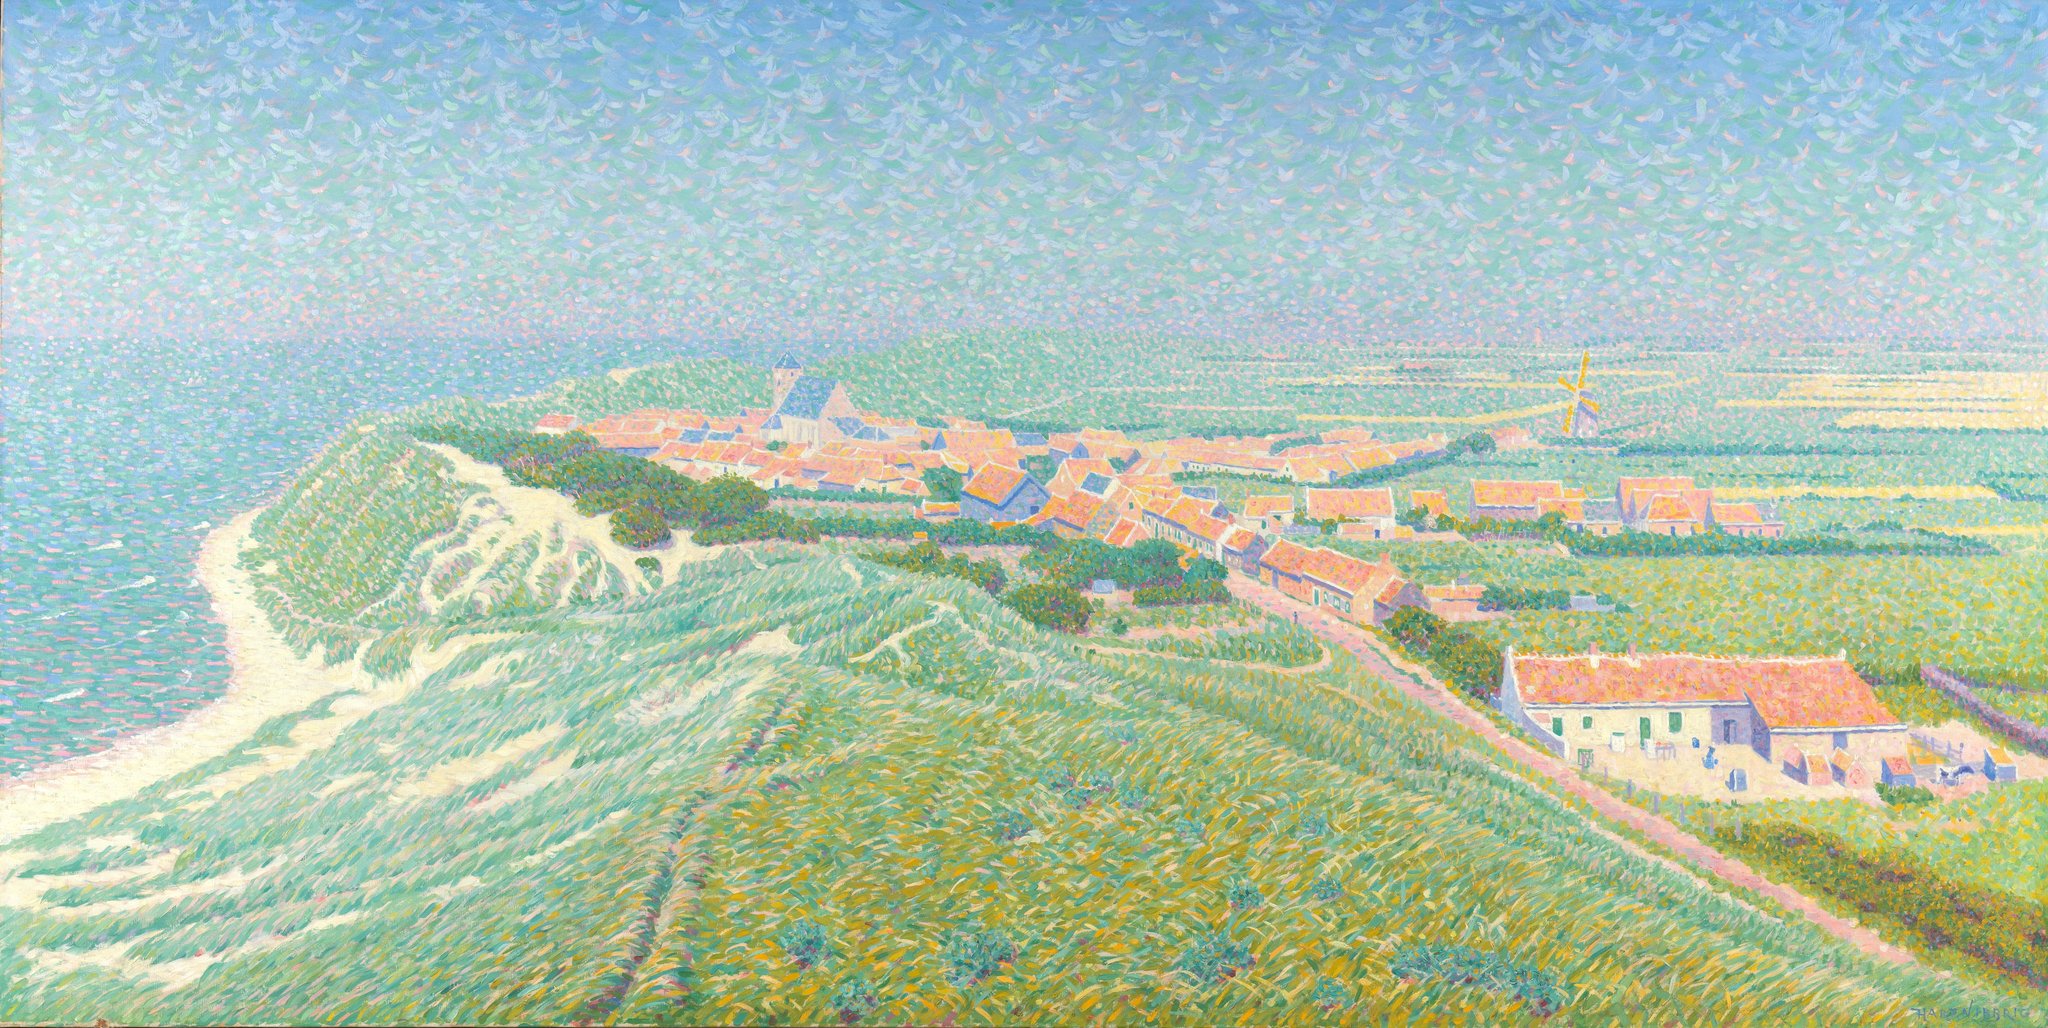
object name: painting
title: View of Zoutelande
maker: ferdinand hart nibbrig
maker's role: draughtsman, painter, print maker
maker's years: 1866-1915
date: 1910-1912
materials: canvas, oil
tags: dune coast, prospect of village, silhouette of village (+ city(-scape) with figures, staffage)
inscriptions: signature: ‘Hart Nibbrig’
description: At the beginning of the 20th century, painters were drawn to the North Sea coast of the province of Zeeland. Every summer an artists’ colony gathered in the charming seaside resort of Domburg on Walcheren. Hart Nibbrig even had a summer house built in nearby Zoutelande in 1911. From a high vantage point in the dunes he painted the sweltering summer light.